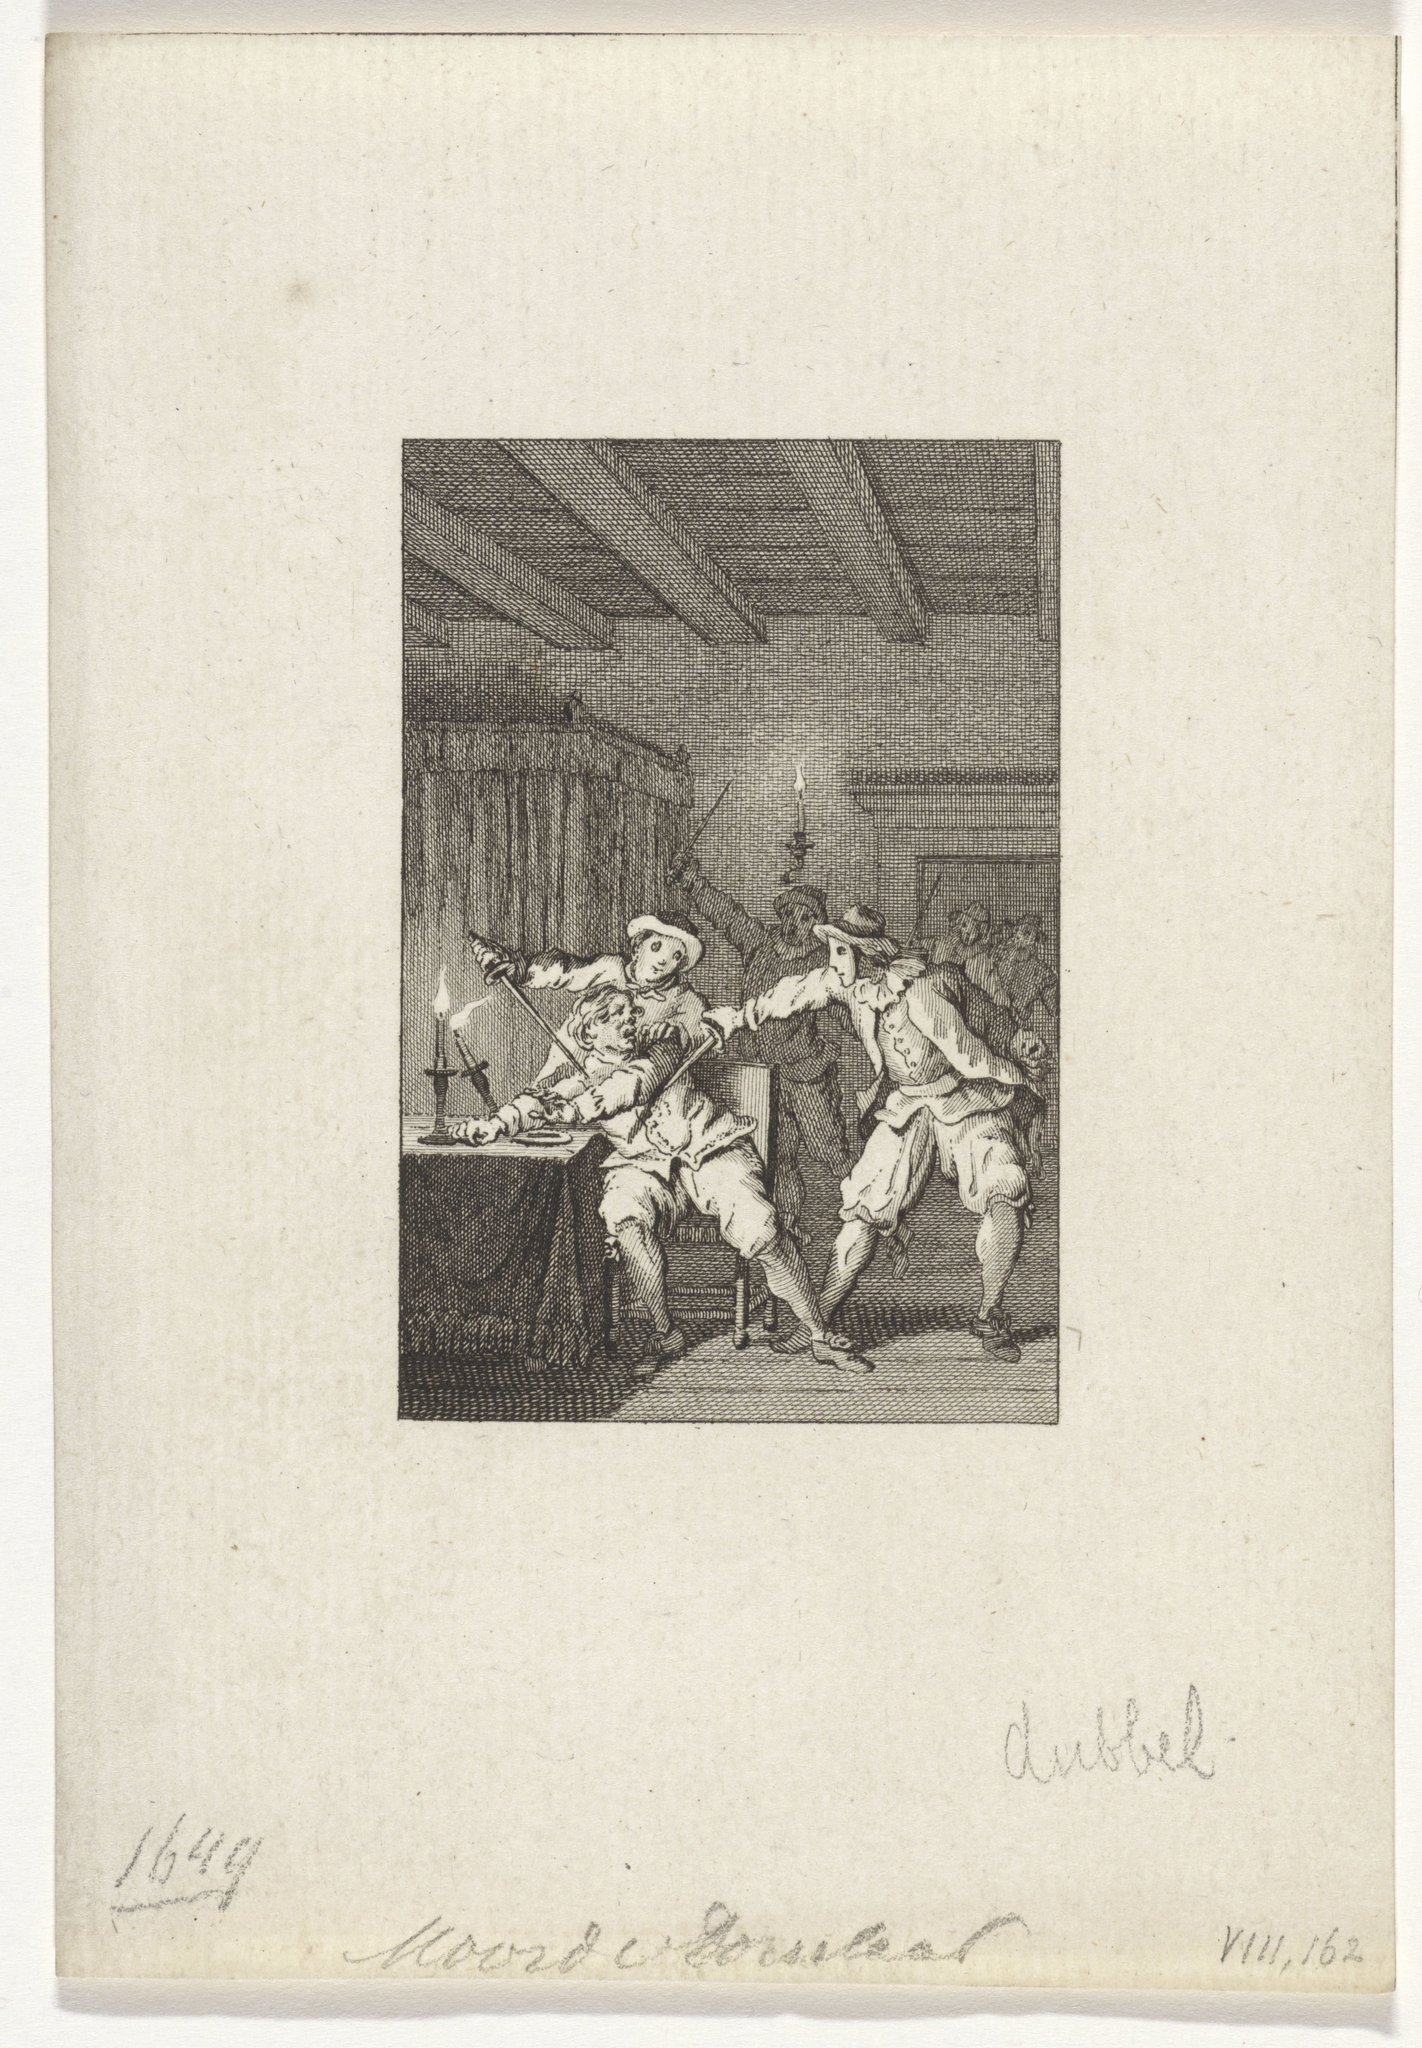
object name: history print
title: Moord op Isaäc Doreslaer, 12 mei 1649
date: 1783-1795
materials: paper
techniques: etching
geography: amsterdam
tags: enkhuizen, the hague, mask, attempt, political murder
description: Illustratie voor: J. Fokke. Geschiedenissen der Vereenigde Nederlanden voor de vaderlandsche jeugd. Amsterdam: Johannes Allart, 1783-1795, 25 delen. deel VIII.